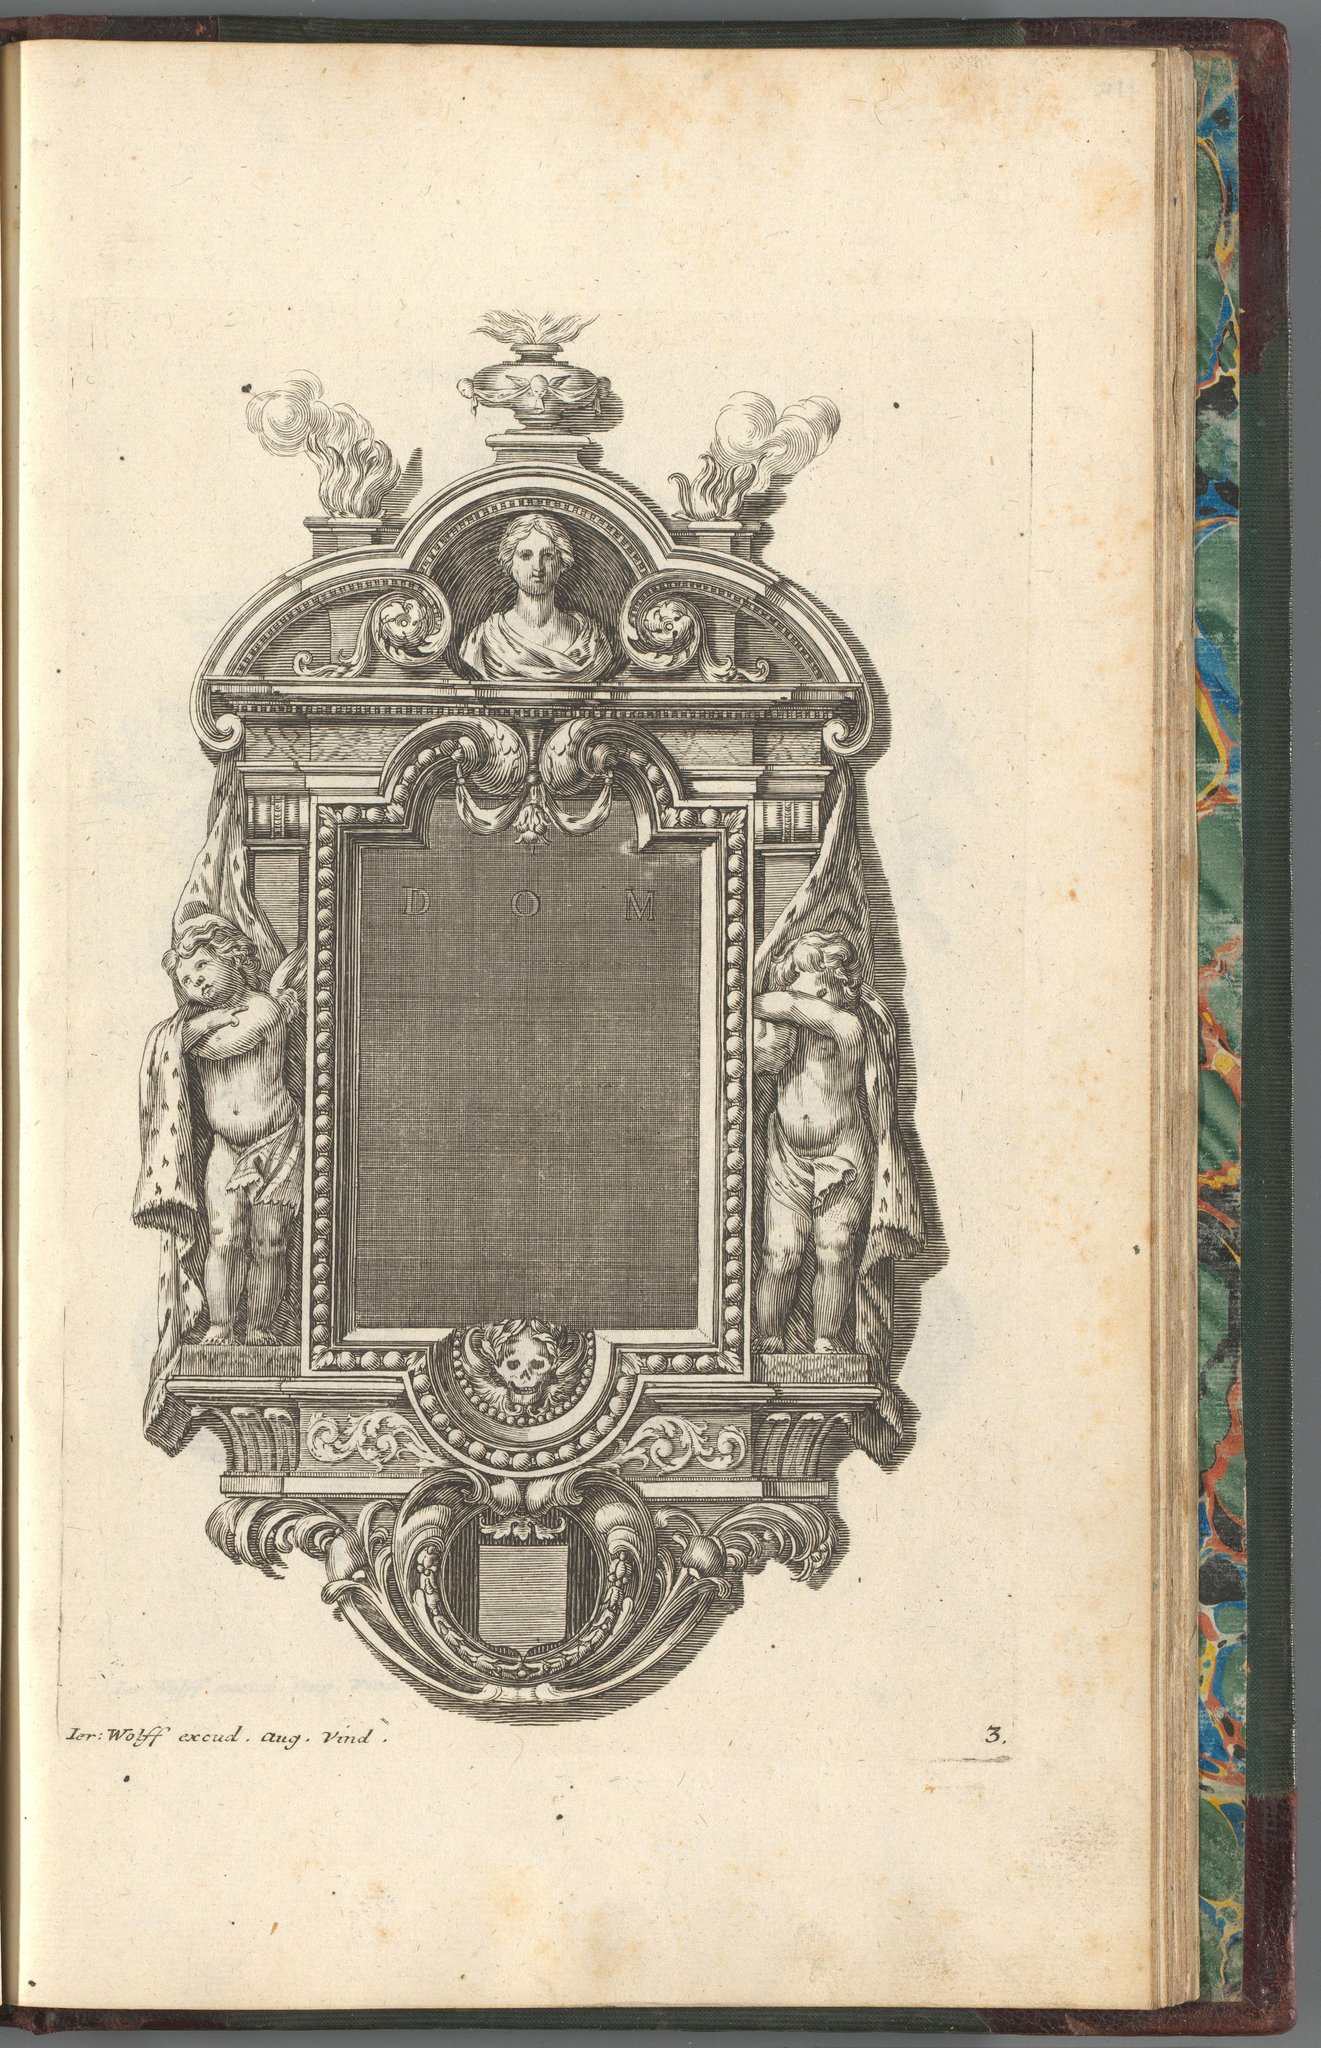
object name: album leaf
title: Epitaphien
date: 1686-1724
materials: paper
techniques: engraving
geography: augsburg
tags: ornaments ~ art, epitaph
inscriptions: number: ‘3.’, signature: ‘Ier. Wolff excud. Aug. Vind.’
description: Een epitaaf met bovenaan een buste in een halfronde nis, daaronder een rechthoekig veld met de letters DOM. Prent afkomstig uit een serie van zeven grafschriften. Prent maakt deel uit van een album. Gespiegelde kopie naar Frans origineel.